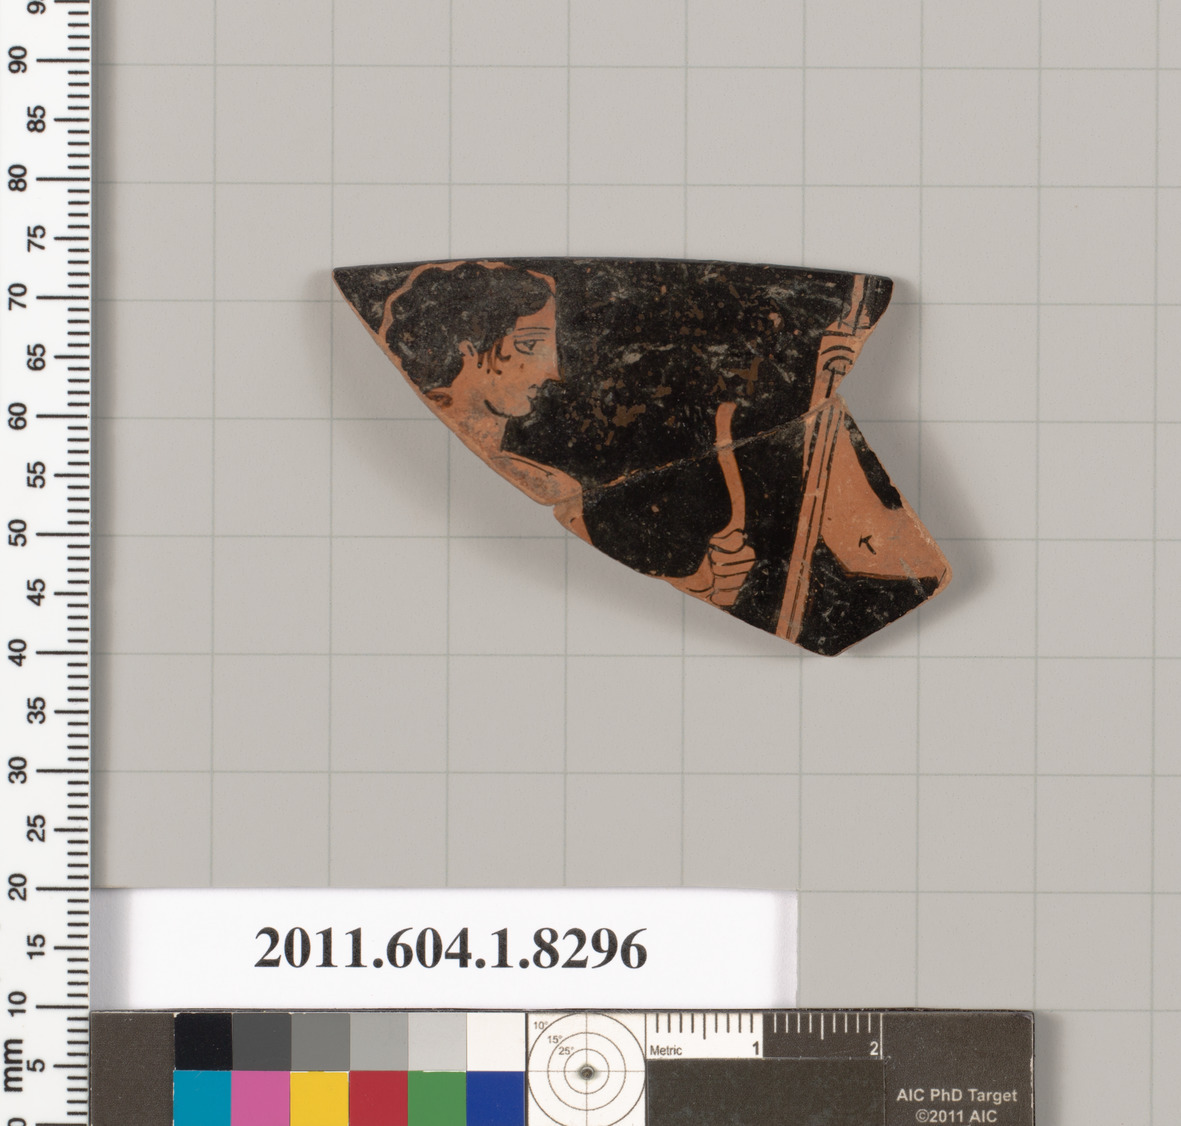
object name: kylix fragment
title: Terracotta rim fragment of a kylix (drinking cup)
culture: greek, attic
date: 425-401 BCE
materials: terracotta